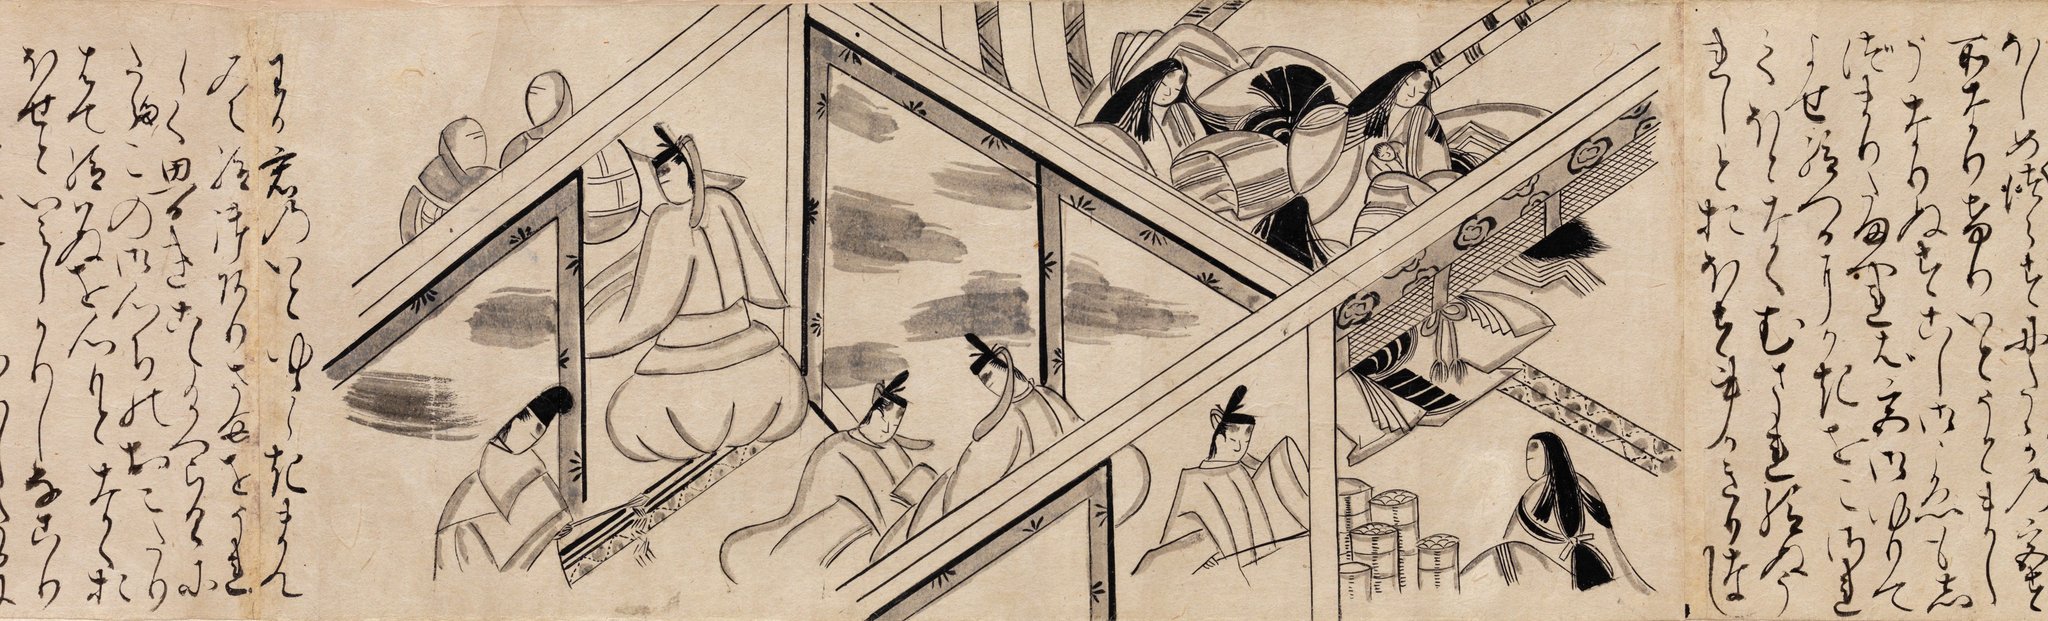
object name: handscroll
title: "Heartvine" ("Aoi") chapter from The Tale of Genji (Genji monogatari)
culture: japanese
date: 1501-1600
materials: ink, paper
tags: men,women